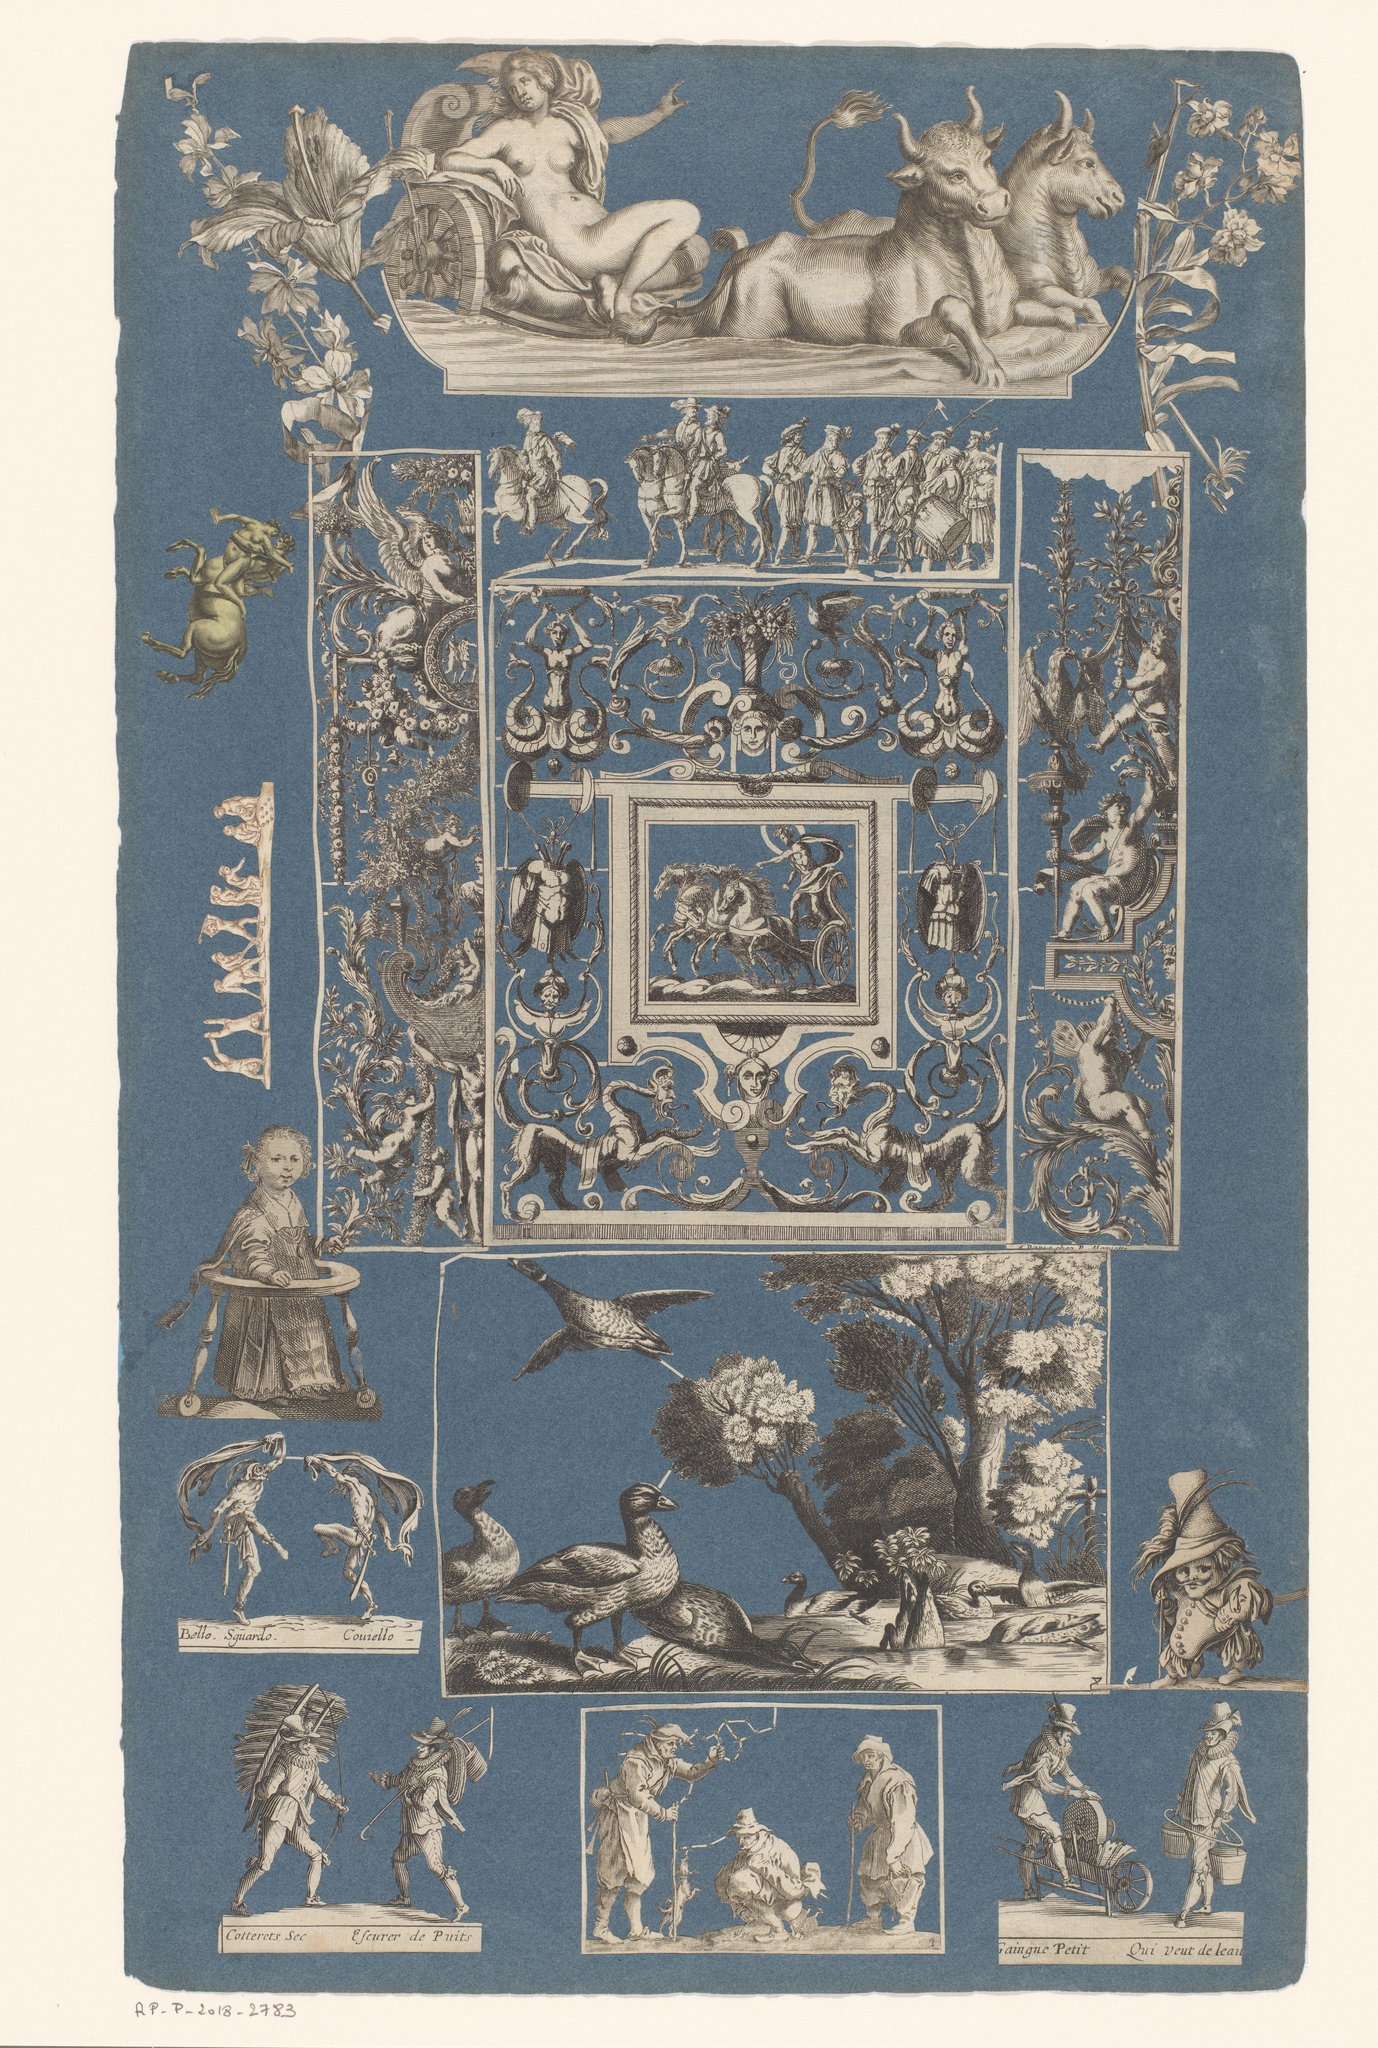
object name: print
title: Collage van uitgeknipte prenten geplakt op een albumblad van blauw papier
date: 1680-1720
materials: paper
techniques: engraving, etching, snipping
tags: urination, water-birds: duck, triumph of amphitrite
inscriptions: collector's mark: Lugt 2760, collector's mark: Lugt 2228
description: Blauw albumblad beplakt met uitgeknipte prenten van verschillende prentmakers en ontwerpers.